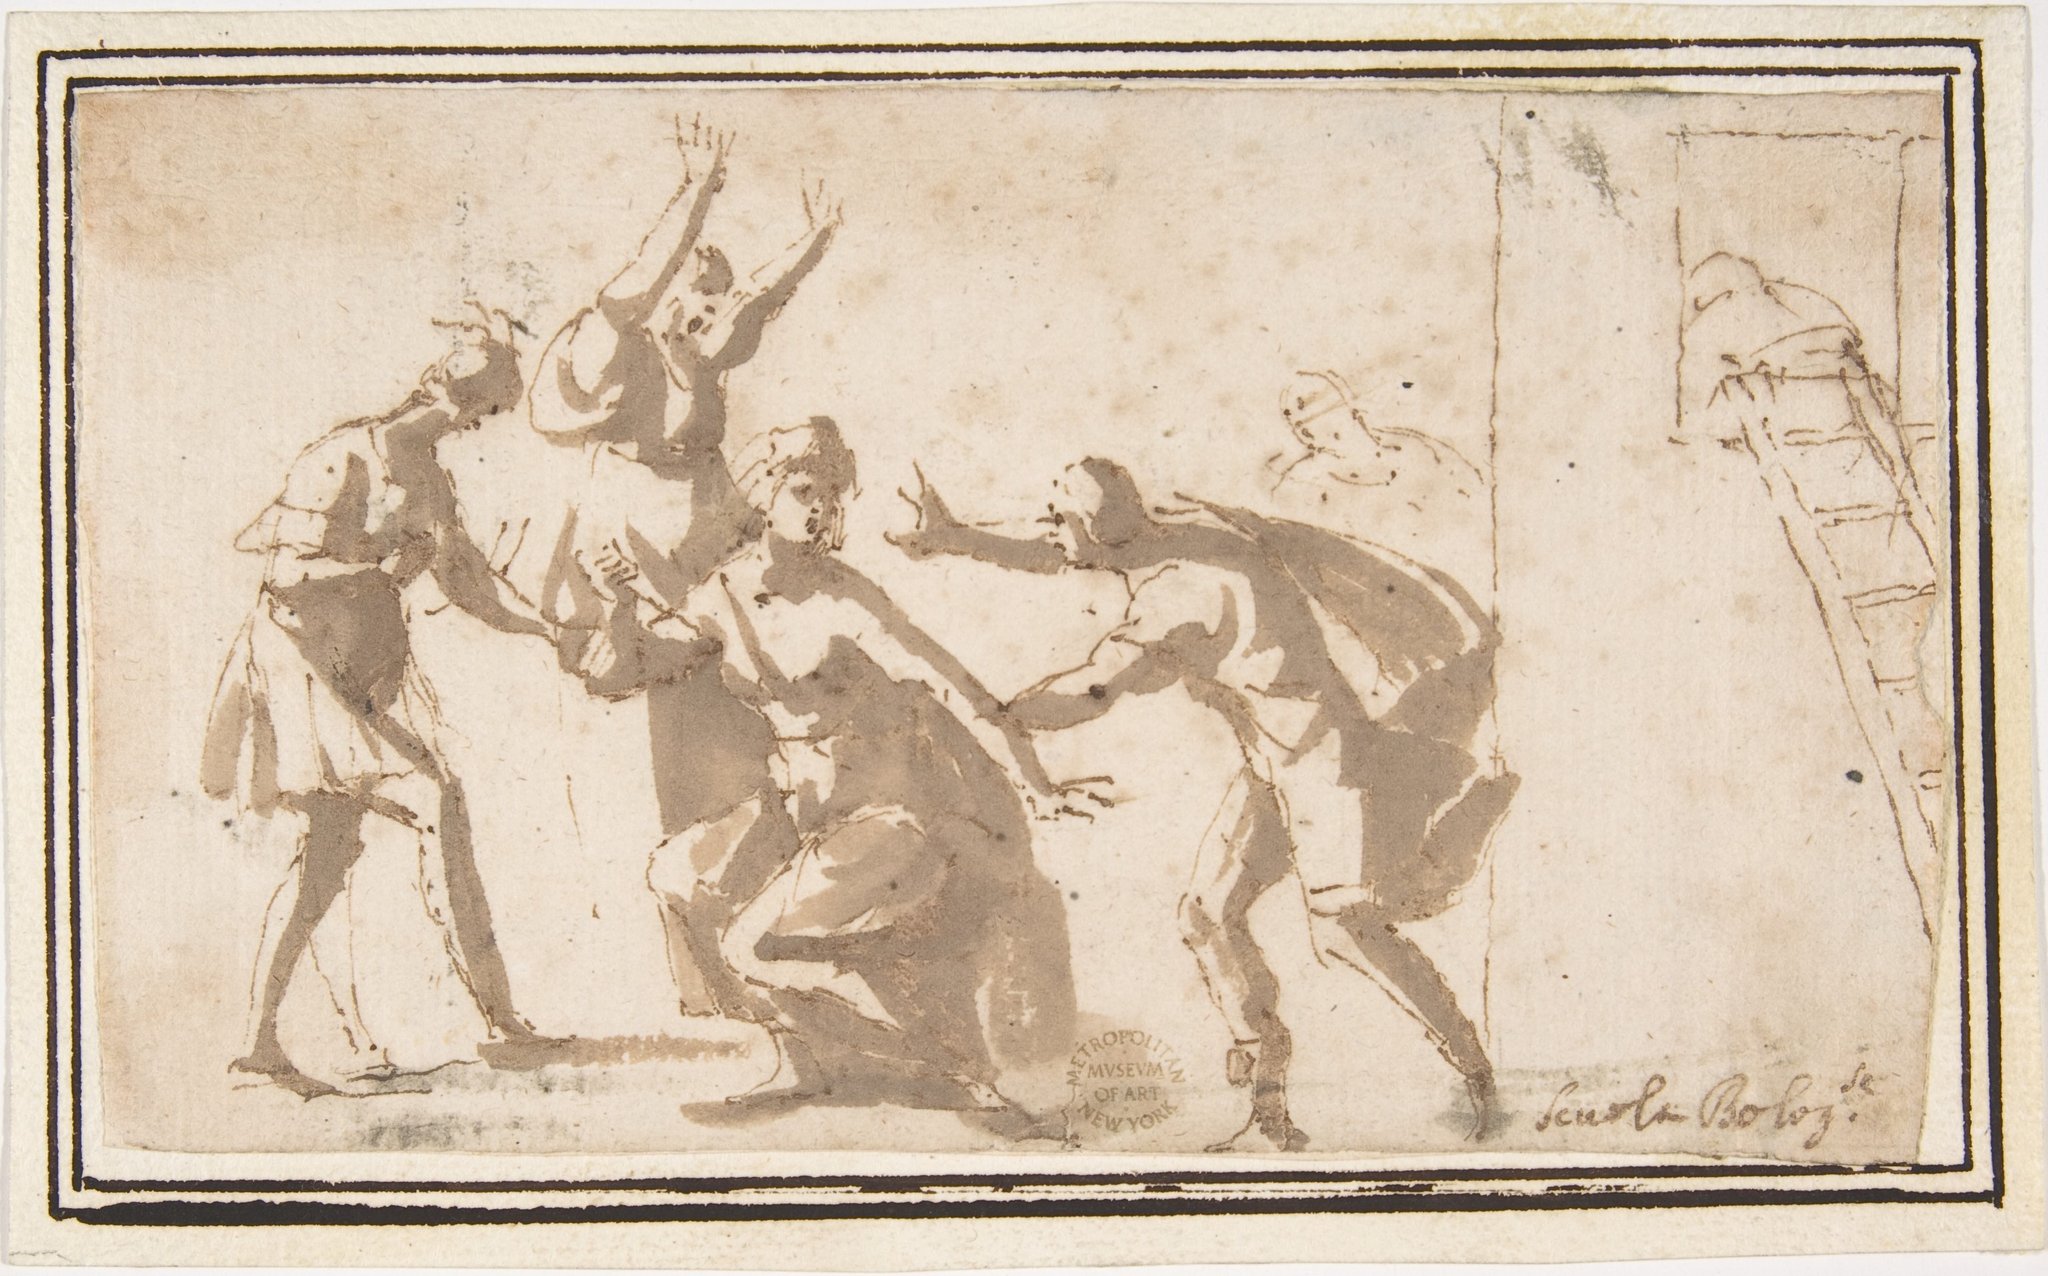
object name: drawing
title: The Death of Lucretia?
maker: francesco allegrini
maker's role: artist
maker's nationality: italian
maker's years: 1615-1679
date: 1624-1663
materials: ink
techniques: brush, pen, wash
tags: men,women,ladders